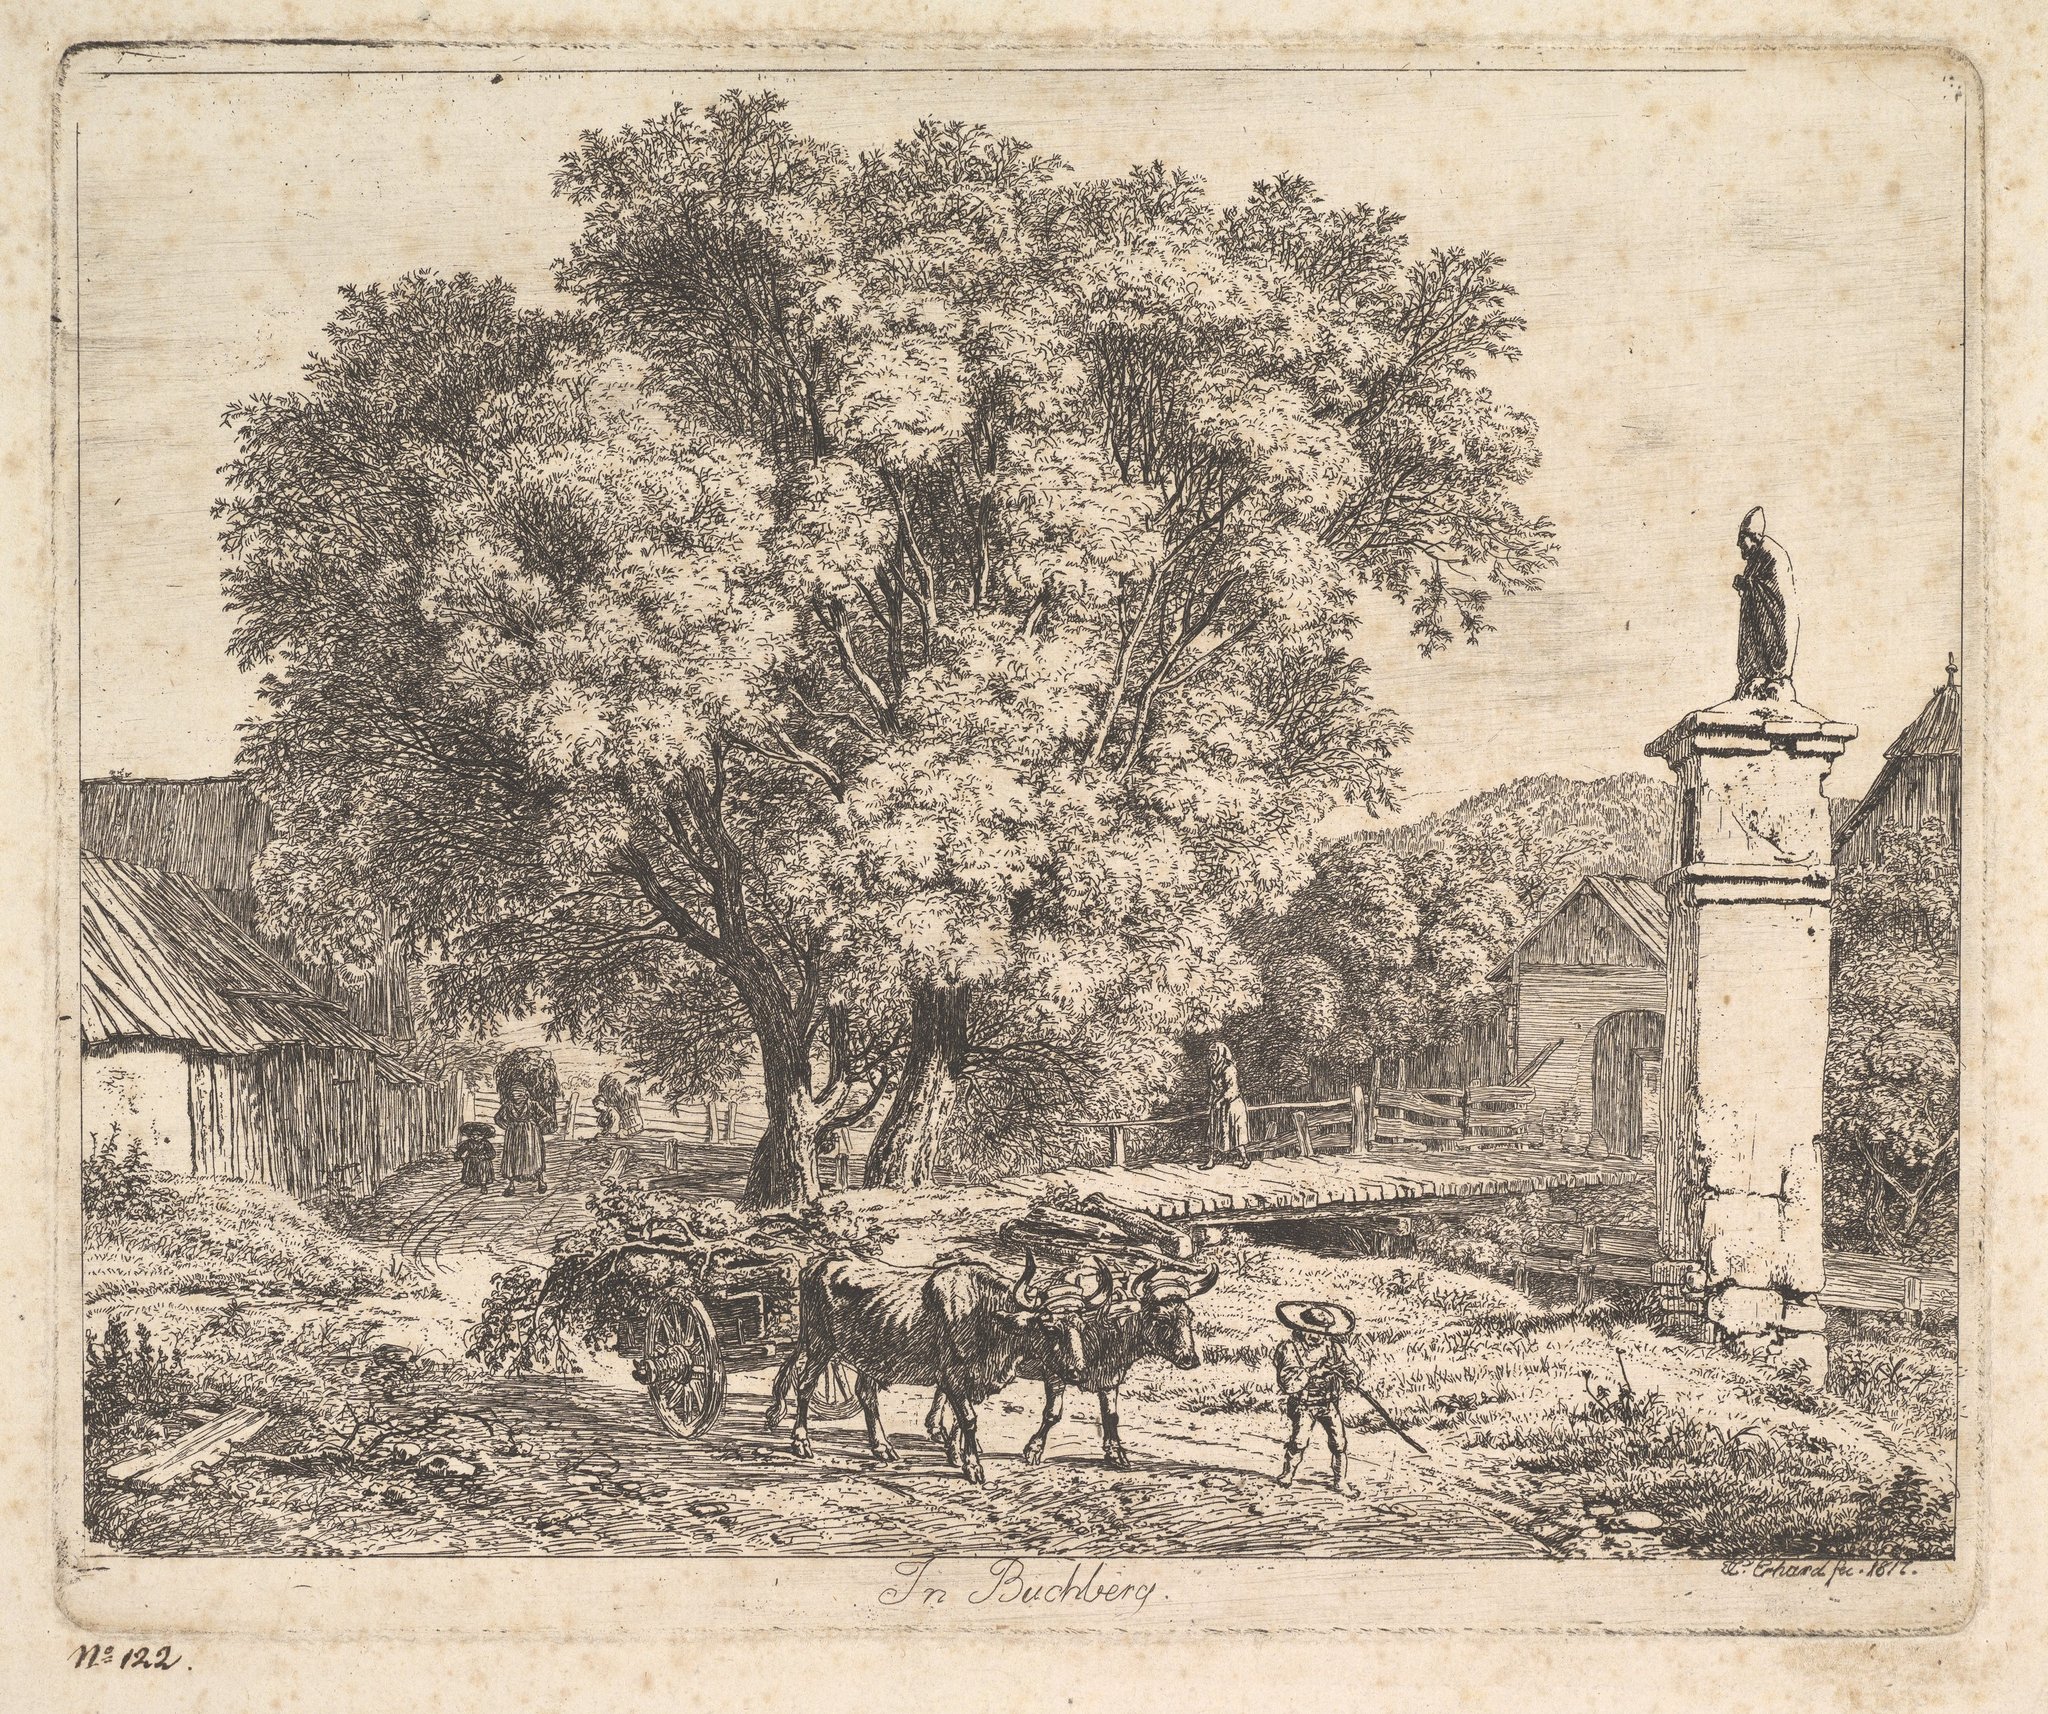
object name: print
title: In Buchberg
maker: johann christoph erhard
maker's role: artist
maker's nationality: german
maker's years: 1795-1822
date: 1817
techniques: etching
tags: human figures,bulls,trees